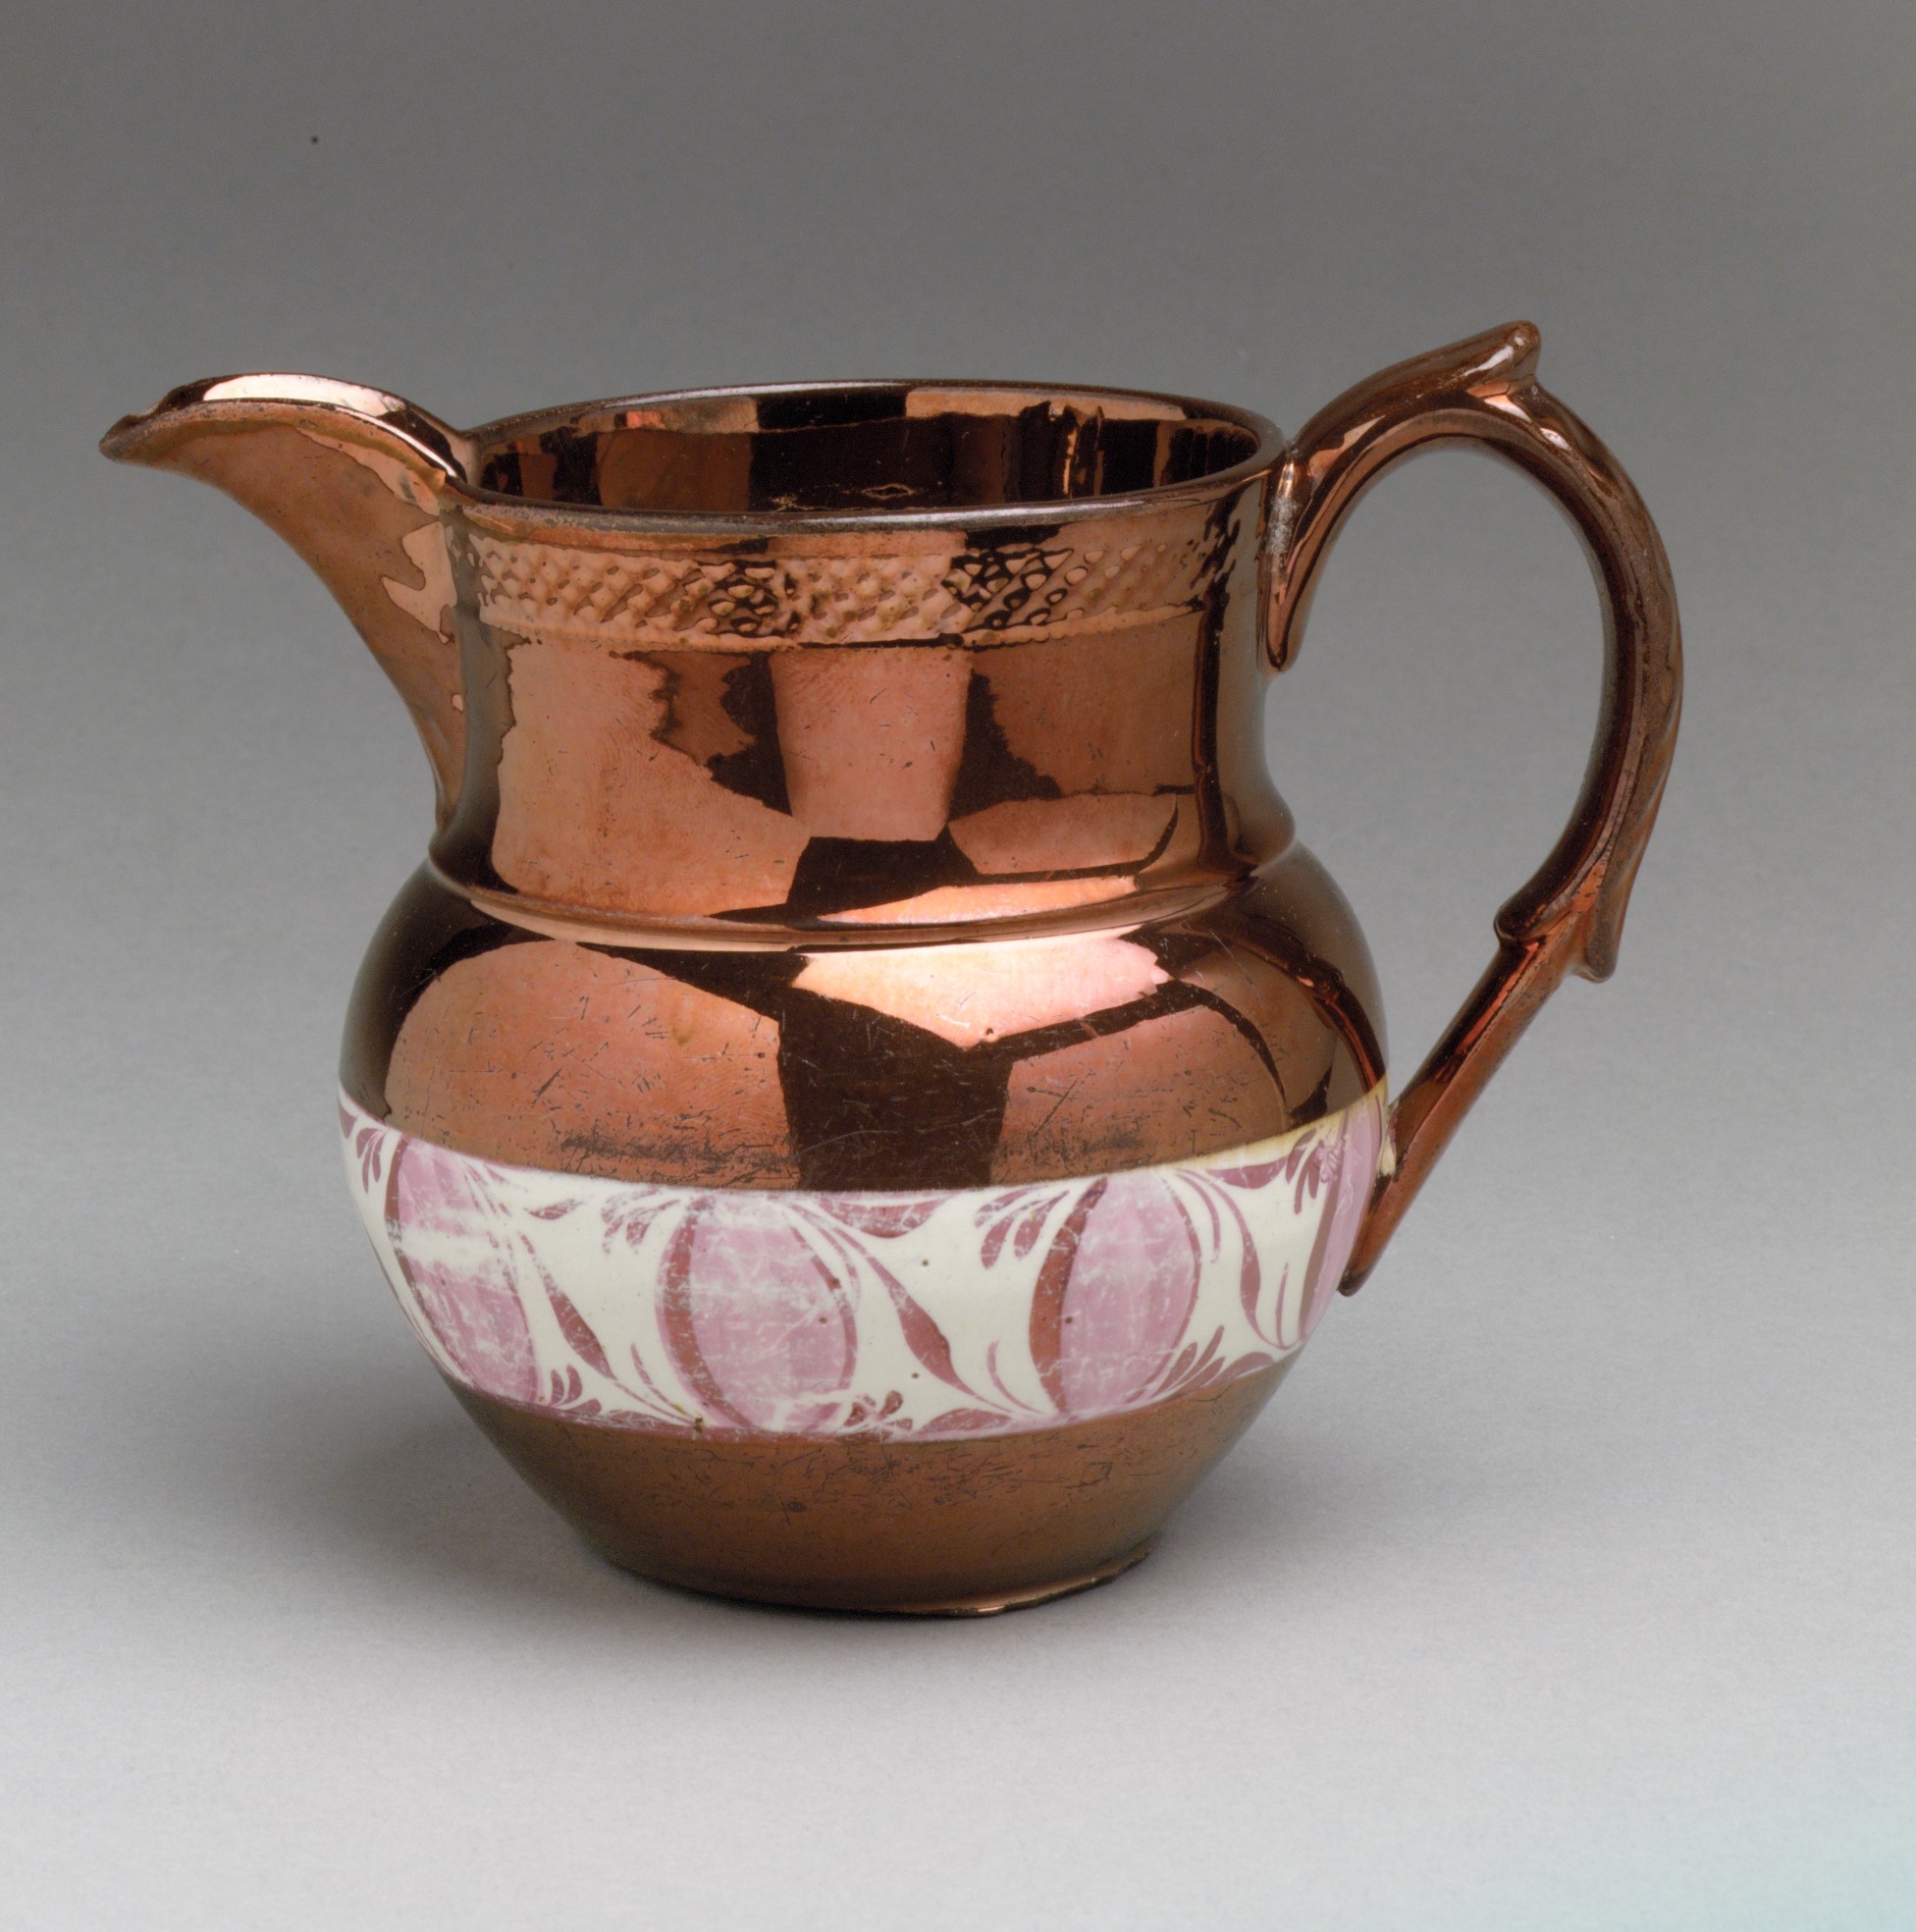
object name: pitcher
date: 1801-1900